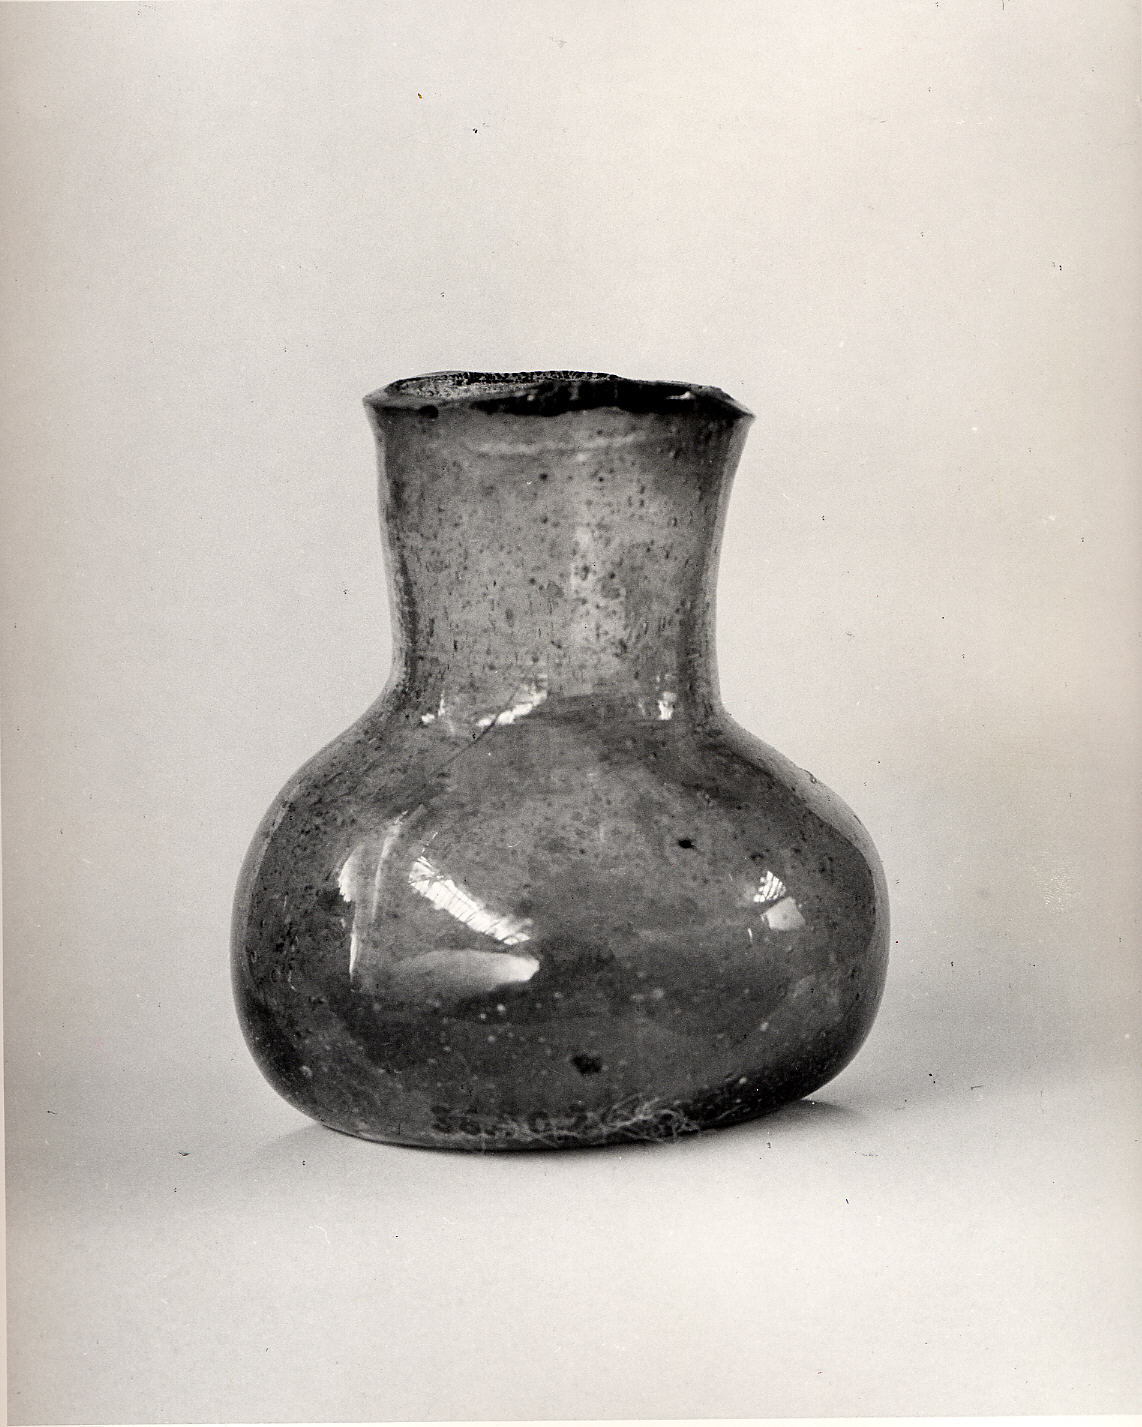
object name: bottle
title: Miniature Bottle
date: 767-1000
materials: glass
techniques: glassblowing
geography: iran